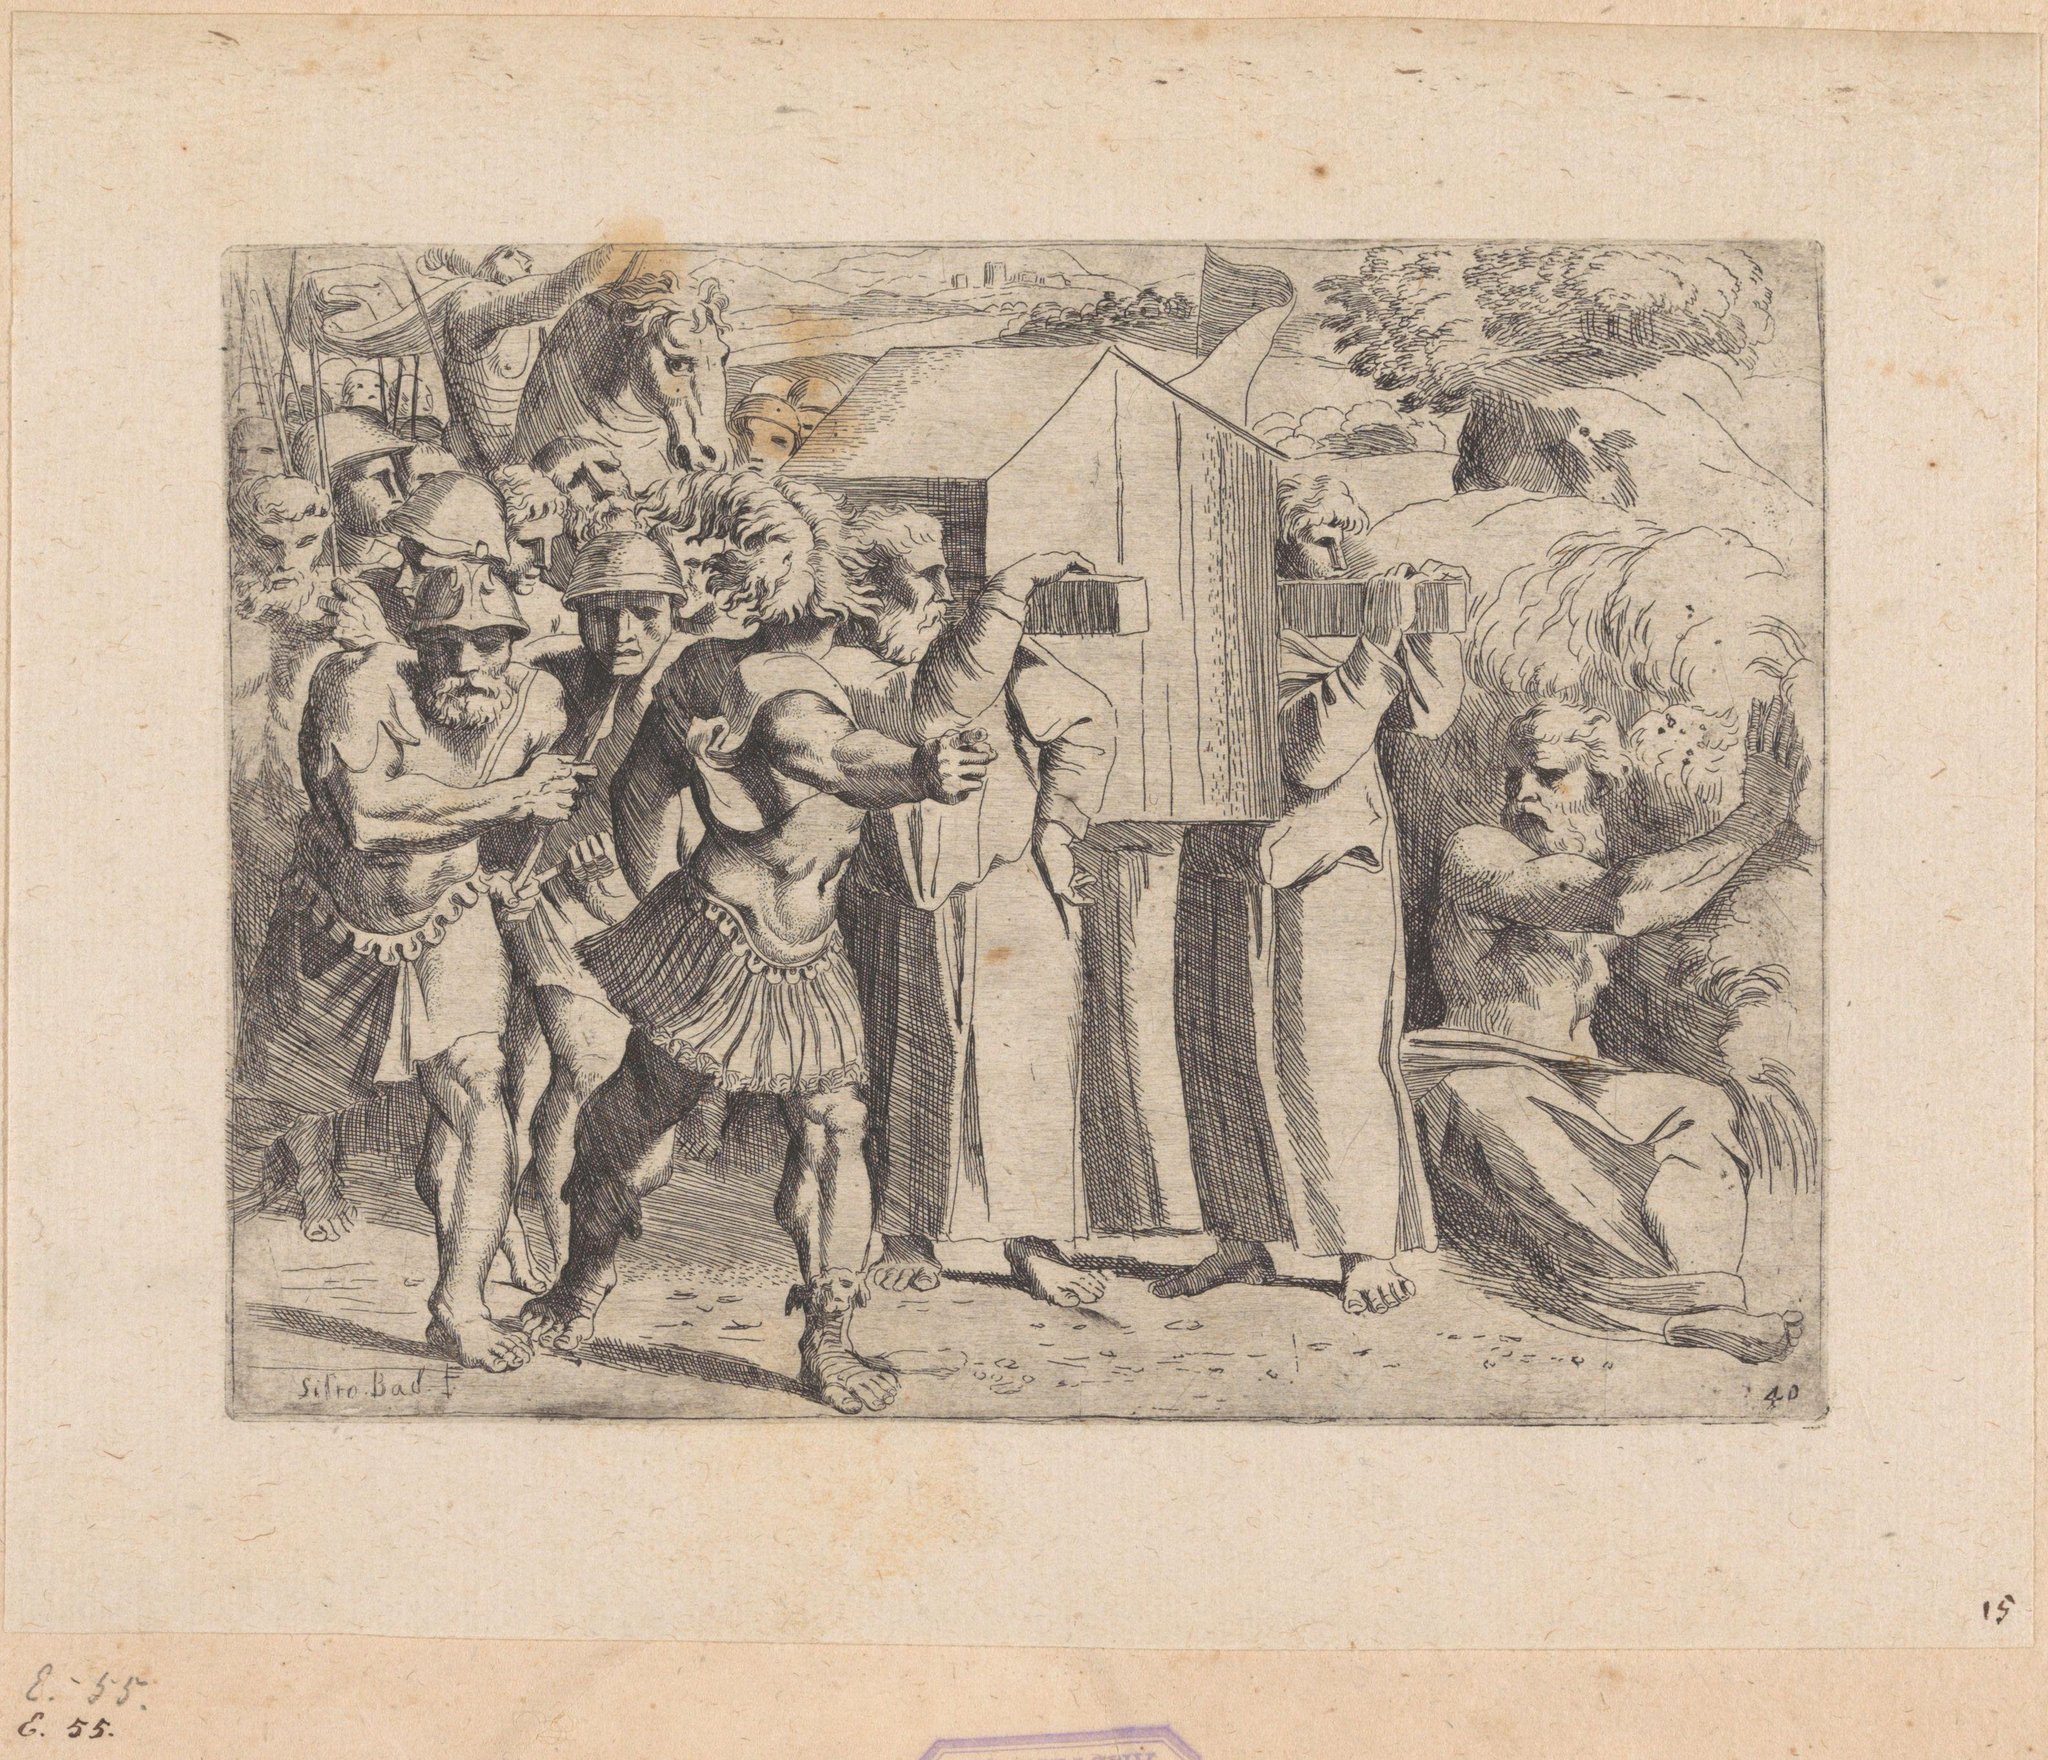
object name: print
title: Bijbelse scènes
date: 1607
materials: paper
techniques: etching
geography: rome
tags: the israelites leave their camp to cross the jordan; the priests, carrying the ark, lead the march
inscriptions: collector's mark: ‘Hinloopen’, number: ‘15’, collector's mark: Lugt 11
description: Op een blad geplakt met rechtsboven handgeschreven in pen in bruin: 135. Prent uit een reeks van 54 genummerde prenten naar schilderingen in de Loggia van Rafael in het Vaticaan.